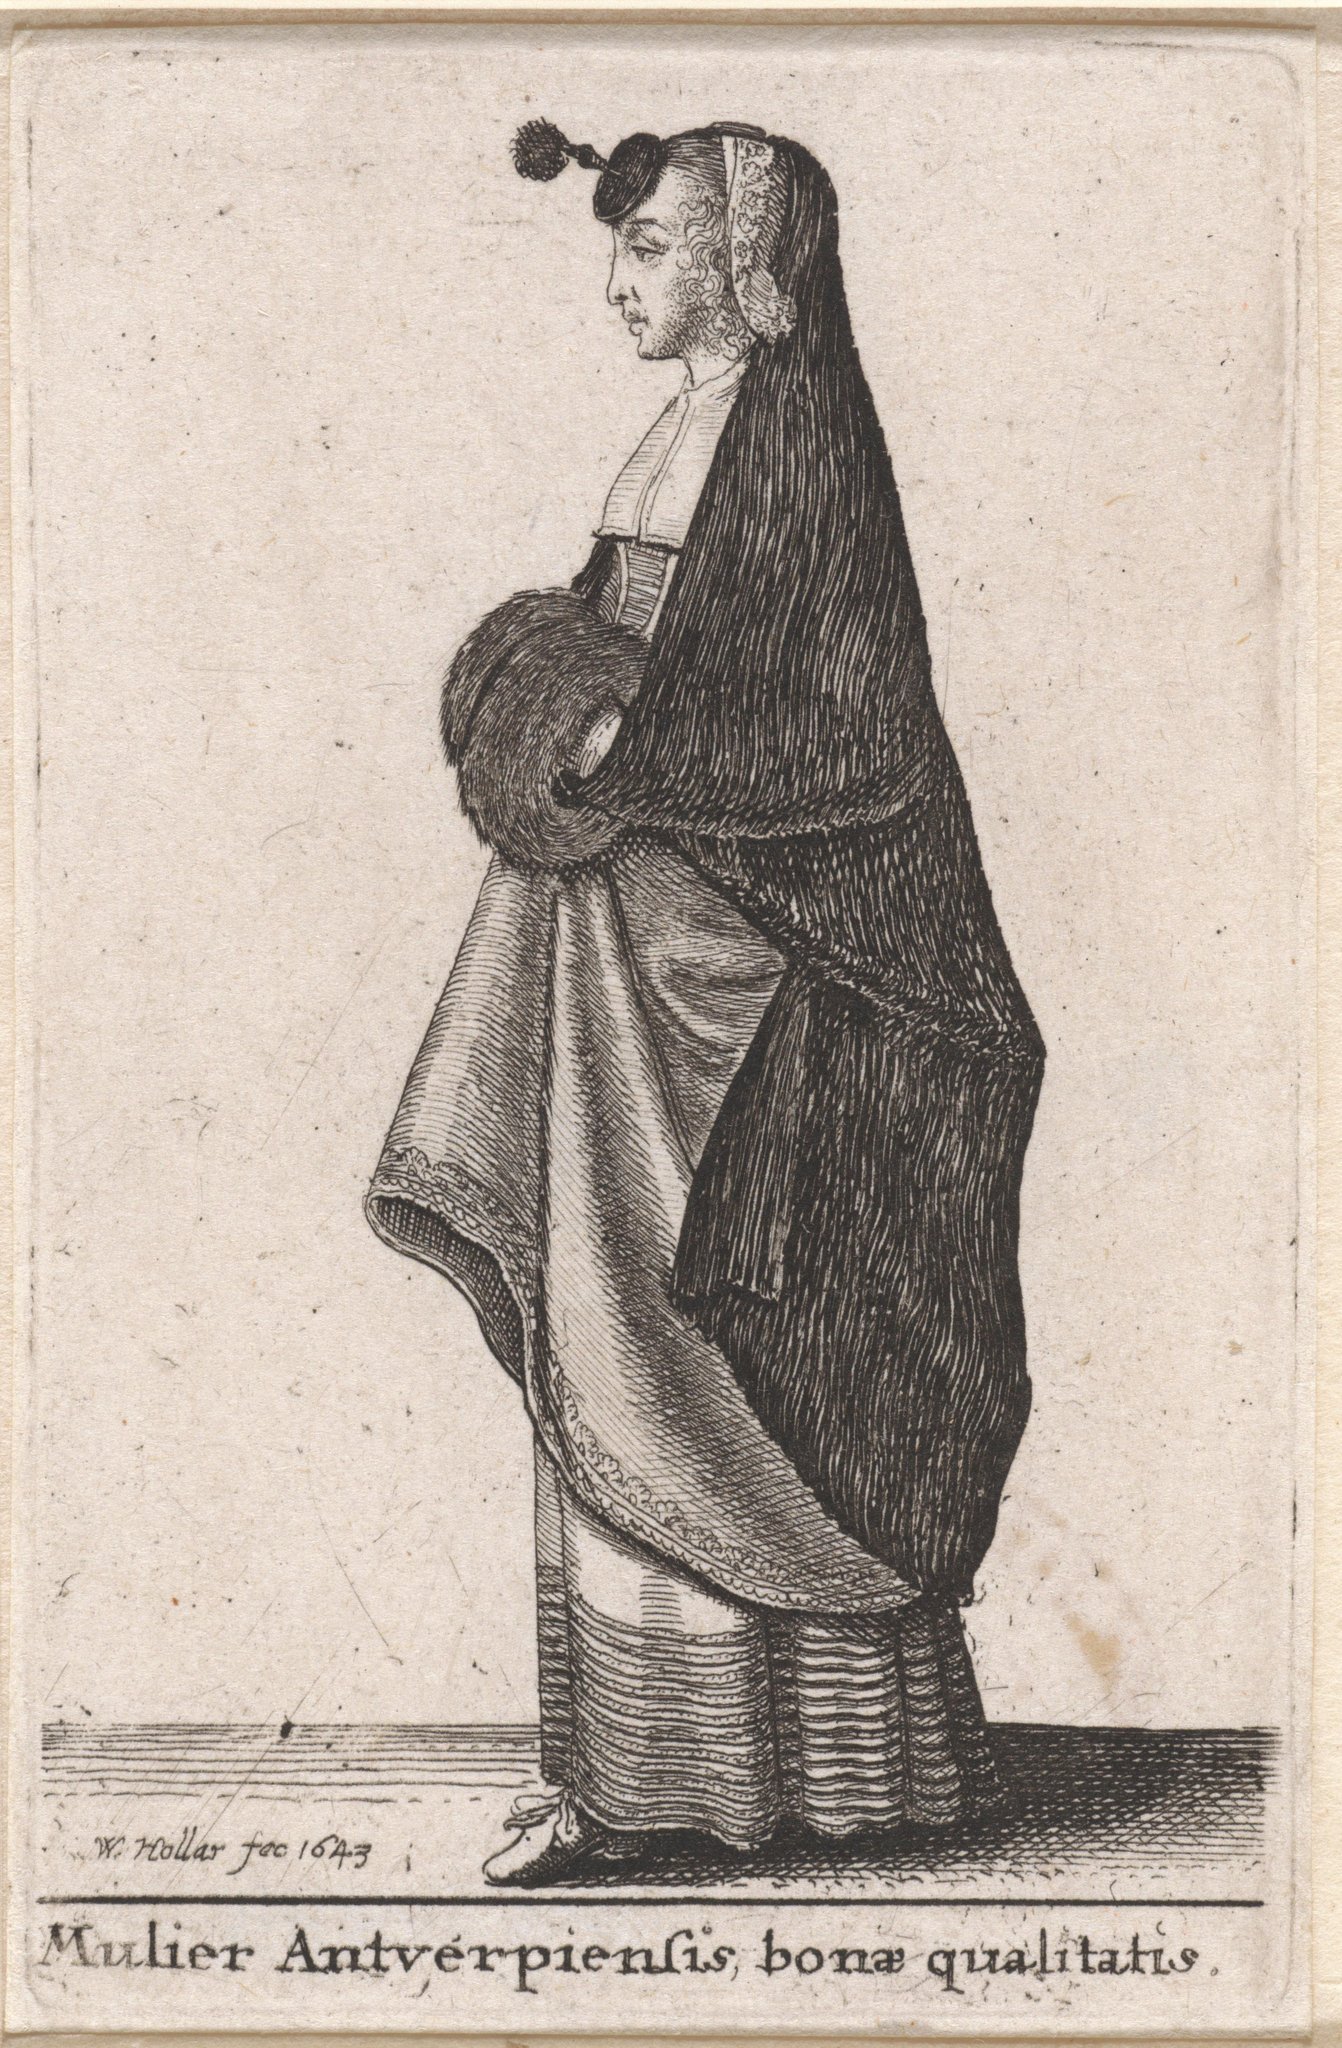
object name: costume print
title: Theatrum Mulierum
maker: wenceslaus hollar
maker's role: draughtsman, print maker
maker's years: 1607-1677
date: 1643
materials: paper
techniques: etching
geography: london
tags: europeans (belgians) (+ women), neck-gear ~ clothing (neckerchief) (+ women's clothes), cape (huik) (+ women's clothes), skirt (underskirt) (+ women's clothes), shoes, sandals (+ women's clothes), skirt (+ women's clothes), muff (+ women's clothes), antwerp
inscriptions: collector's mark: Lugt 240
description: Vrouw van aanzien uit Antwerpen, in profiel naar links, de handen in een grote mof van bont. Ze draagt een donkere huik die is bevestigd aan een rond plat hoedje met opstaand stokje met pluim. Het bovenkleed is van voren opgeschort, zodat het lichte onderkleed zichtbaar is.